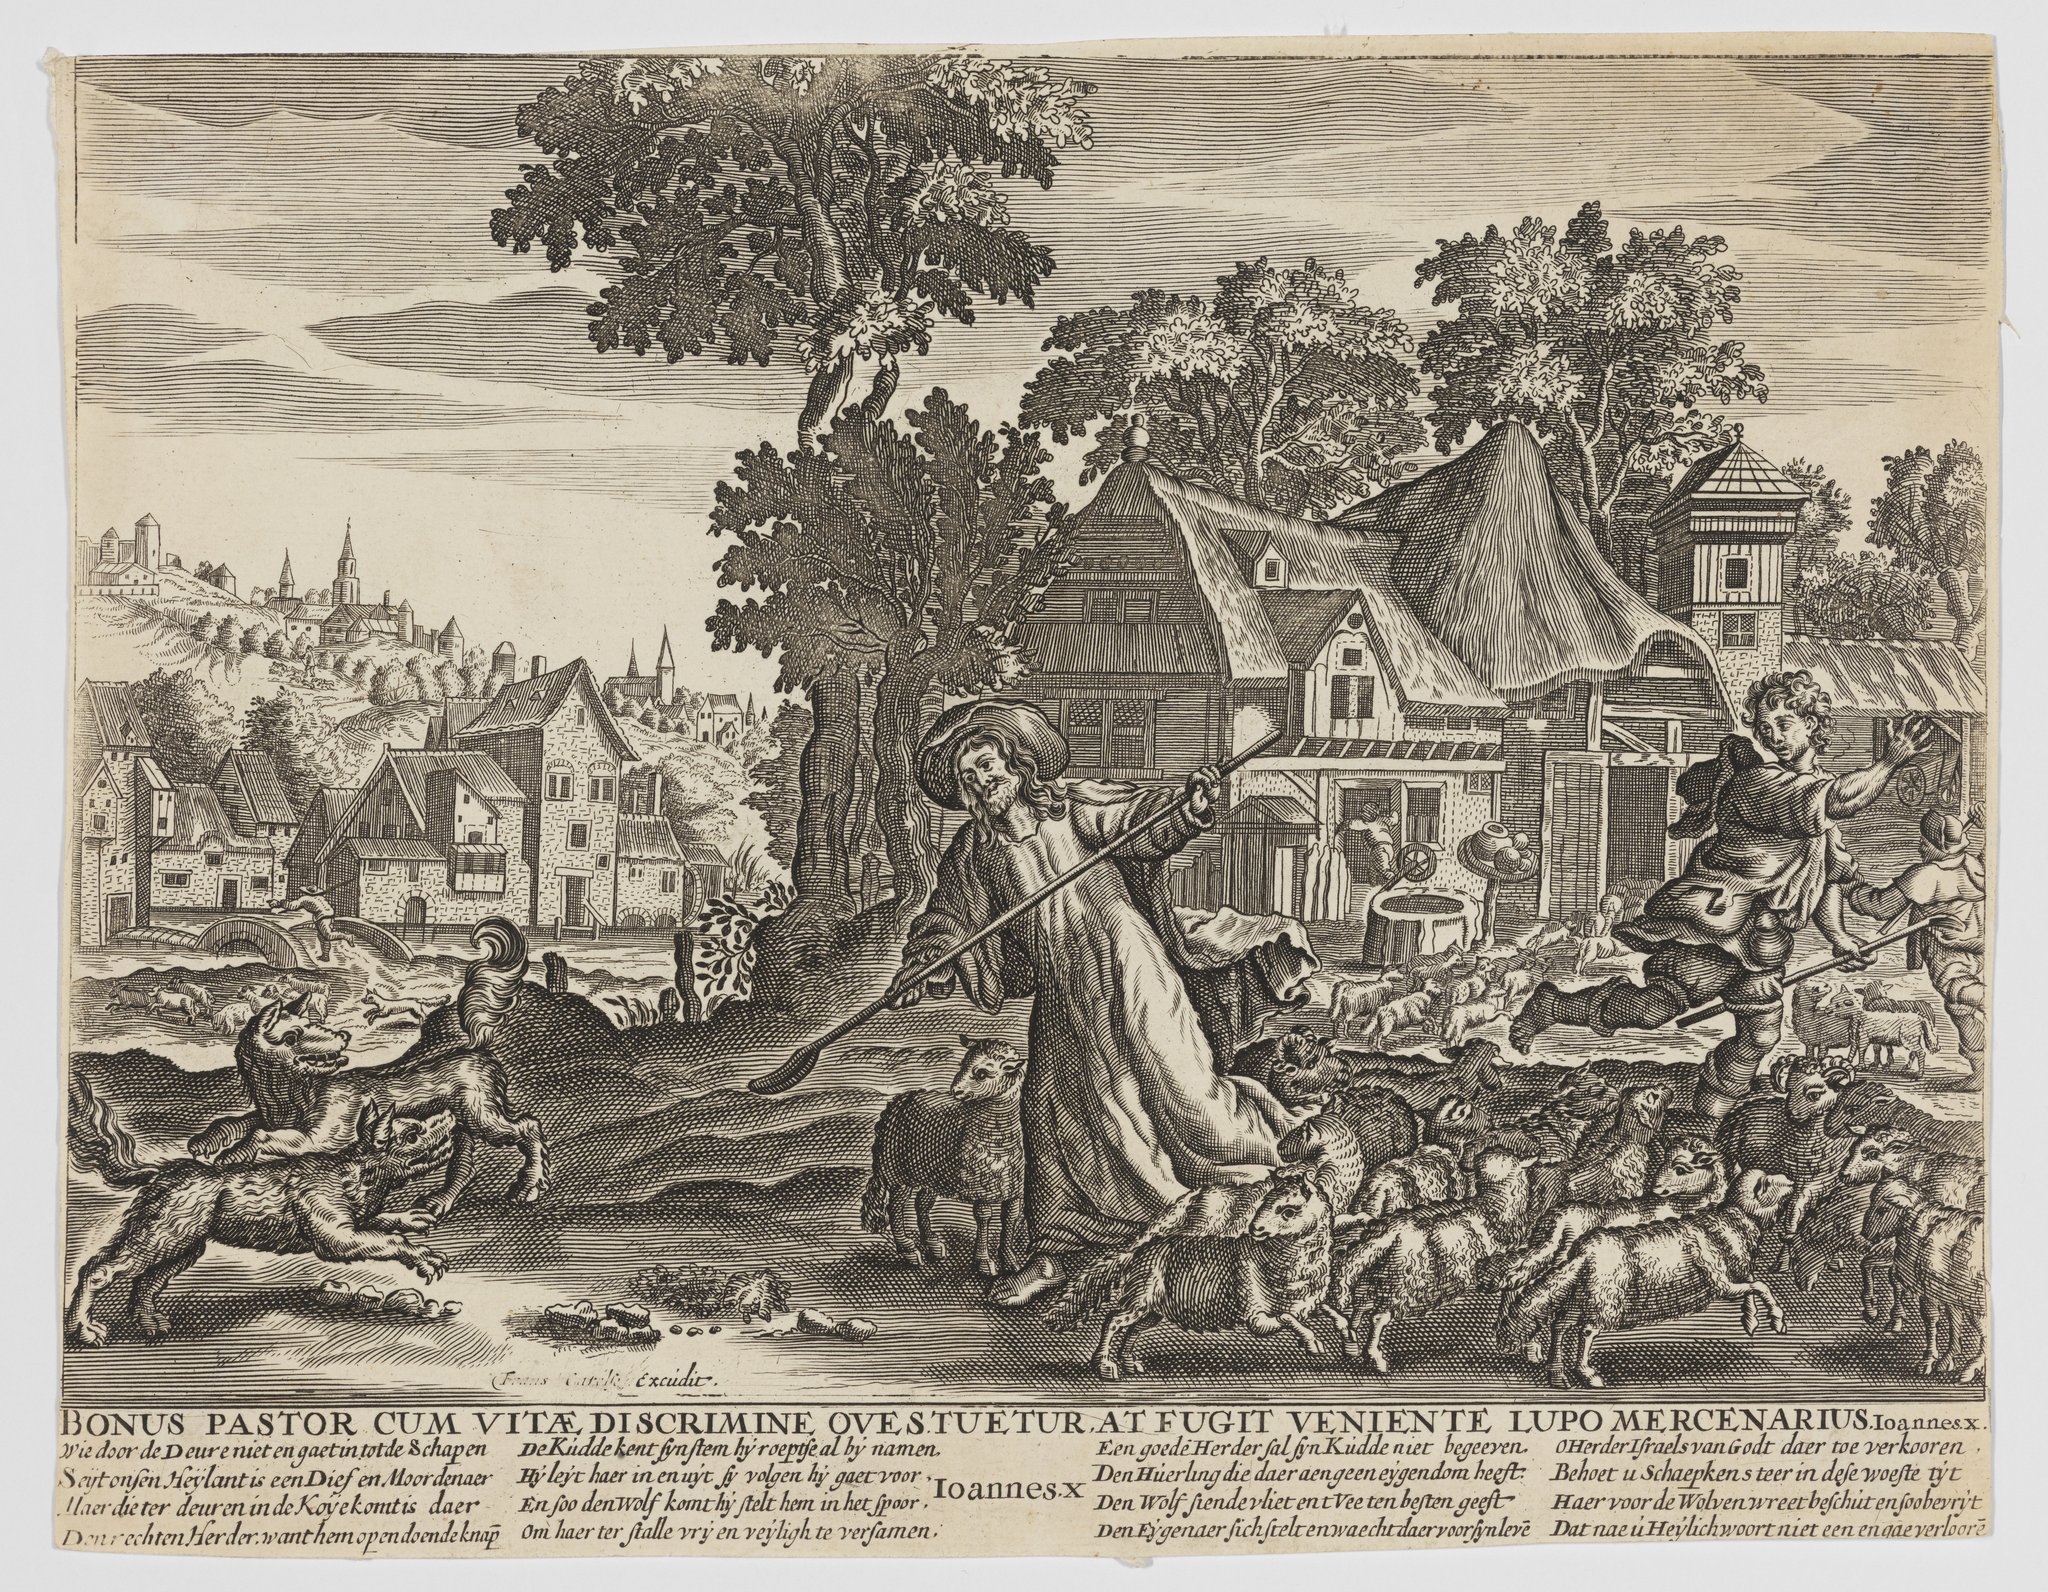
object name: print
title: Christ as the Good Shepherd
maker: anonymous, netherlandish, 17th century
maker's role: artist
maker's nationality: netherlandish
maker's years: 1600-1700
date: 1652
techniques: engraving